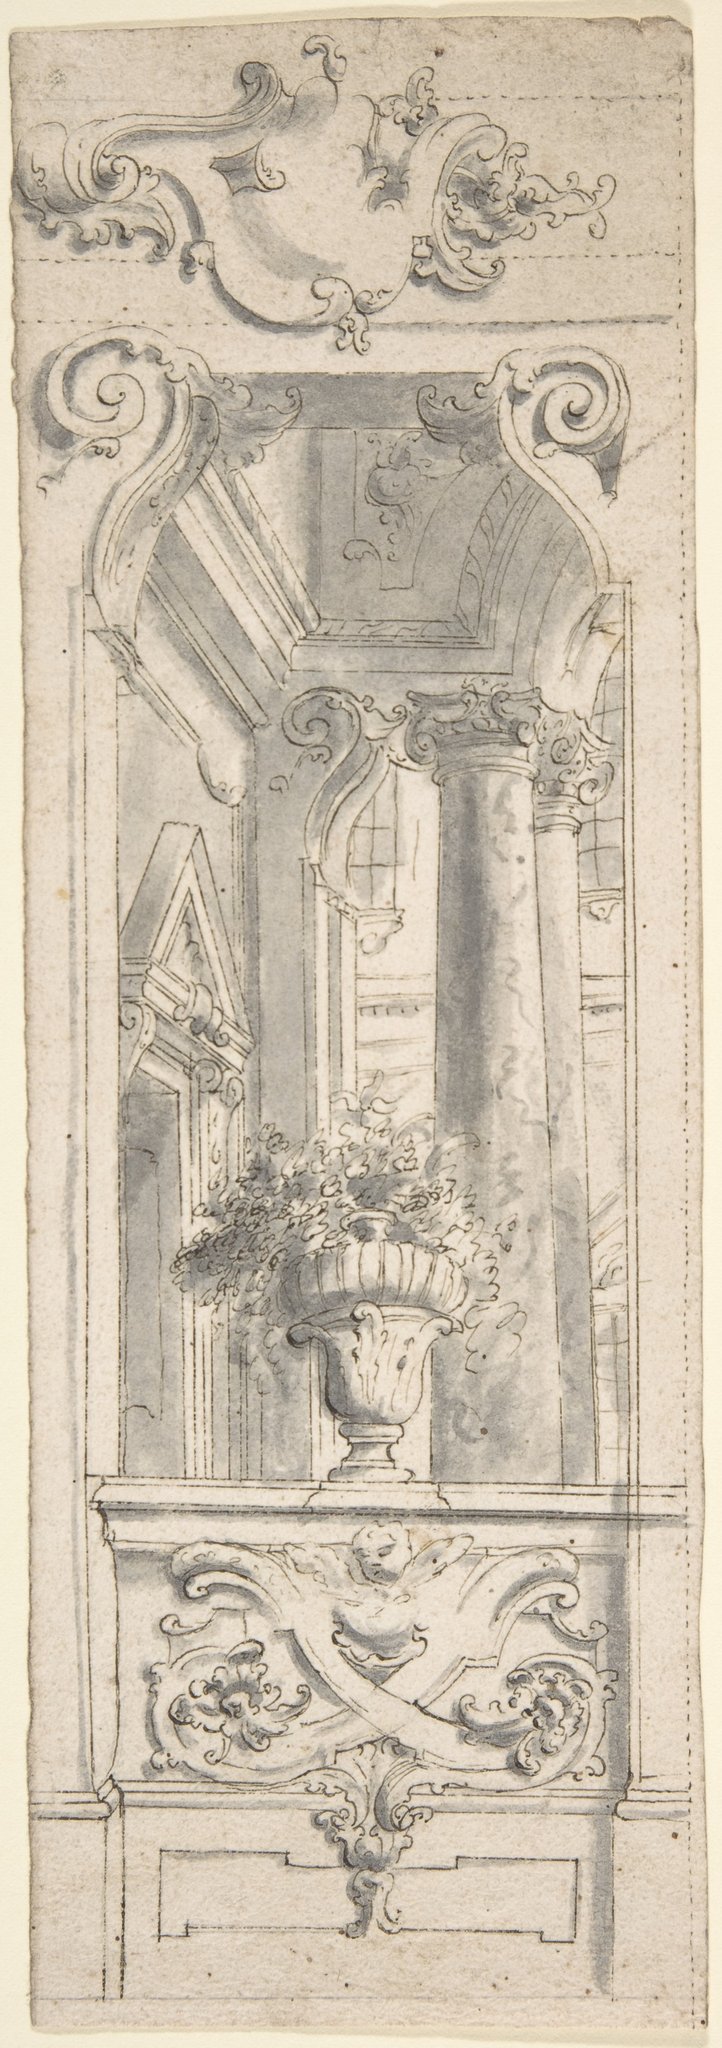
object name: drawing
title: Upper Panel for Painted Wall Decoration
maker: anonymous, italian, north italy, 18th century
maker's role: artist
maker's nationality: italian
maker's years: 1700-1800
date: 1701-1800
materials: ink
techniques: wash